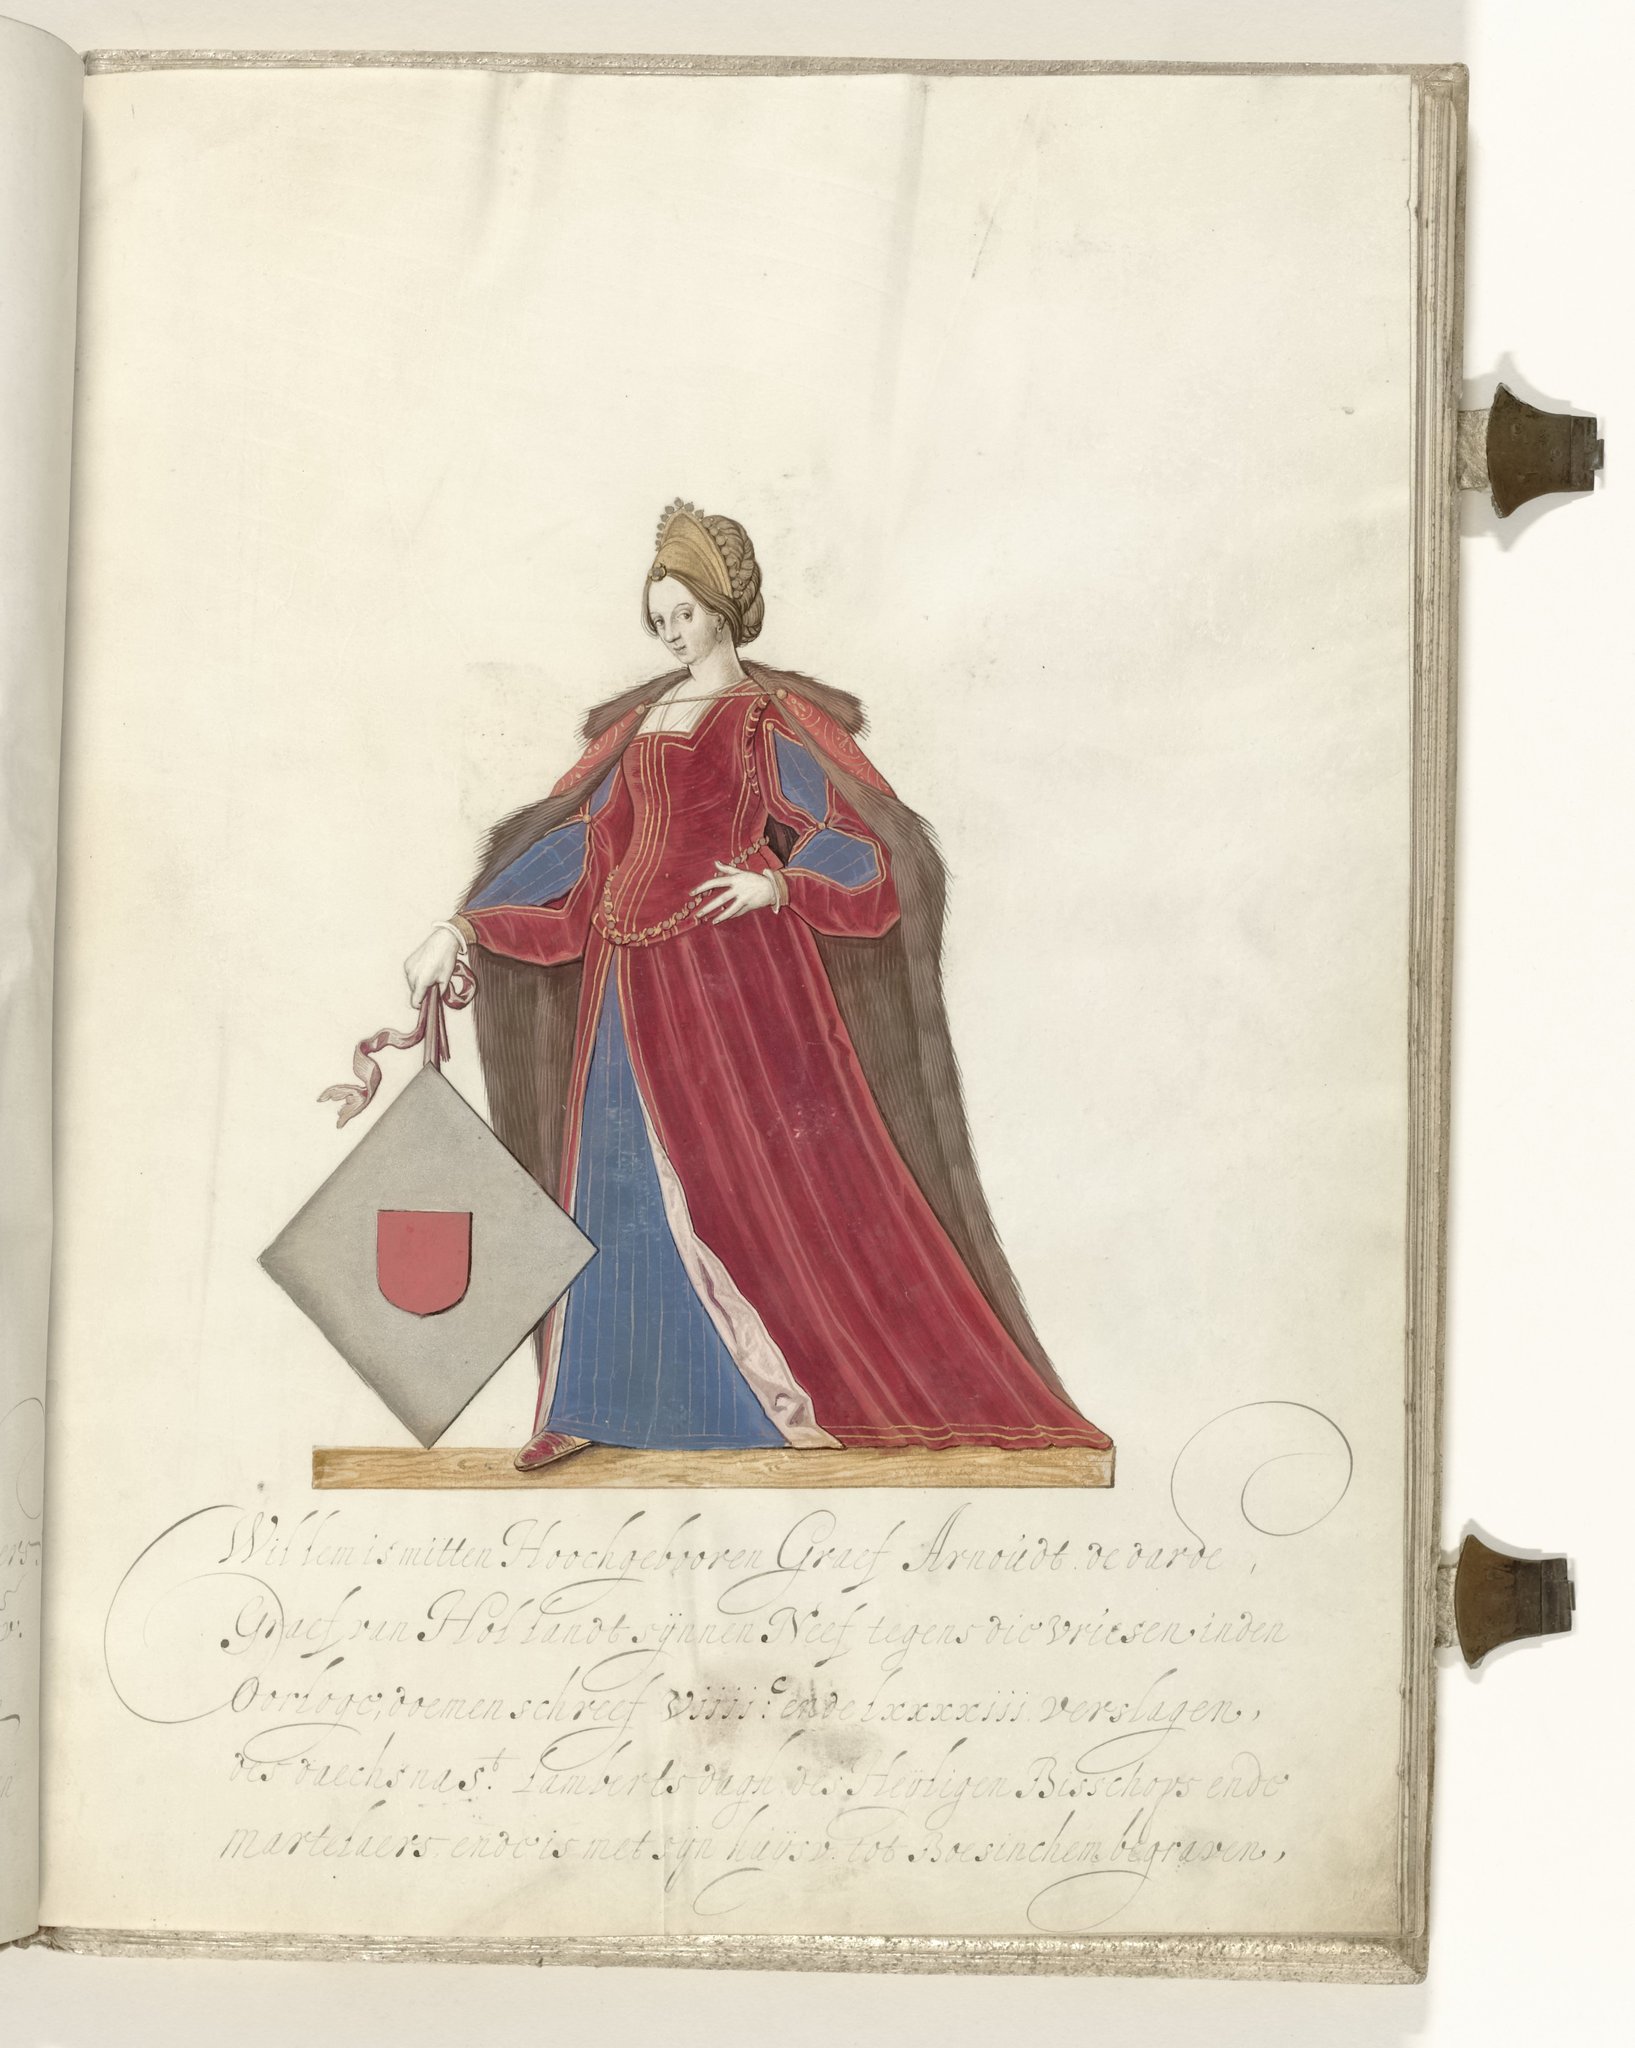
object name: drawing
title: Gravin van Beusichem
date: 1590-1593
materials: paint, gouache, ink, parchment, watercolor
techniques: writing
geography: northern netherlands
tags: culemborg, heren en graven van, heren van beusichem, culemborg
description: Gravin van Beusichem, echtgenote van graaf Willem van Beusichem (Boesinchem). Zij was dochter van de graaf van 'Rijpenscheijden' uit het hertogdom Luxemburg. Staande ten voeten uit met een wapen in de rechterhand. Onderdeel van een geïllustreerd handschrift met de genealogie van de heren en graven van Culemborg.